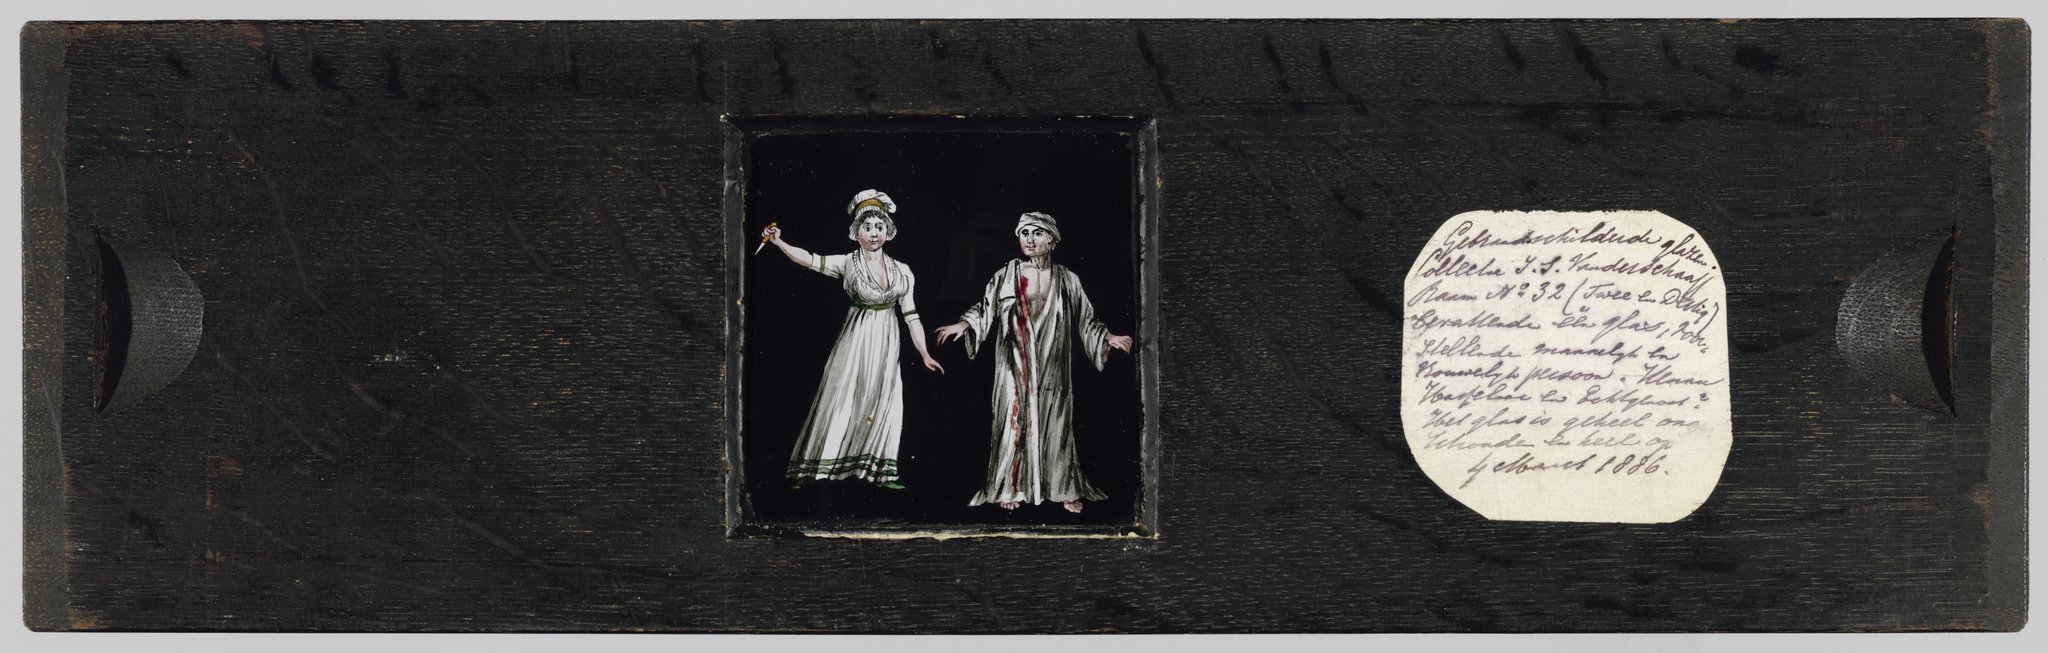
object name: lantern slide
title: Moordenares en haar slachtoffer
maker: Anonymous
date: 1793-1830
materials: glass, wood, oil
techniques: painted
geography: france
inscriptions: label: ‘'Gebrandschilderde glazen. Collectie J. I. Van der Schaaff Baarn. Nr. 32 (twee en dertig) bevattende één glas, voorstellende een mannelijk en vrouwelijk persoon. Het glas is geheel ongeschonden en heel op 4 maart 1886'’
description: Vierkante glasplaat in houten vatting. Een vrouw gekleed in jurk en met muts op, ten voeten uit, met mes in haar geheven hand. Naast haar een man, ten voeten uit, in witte kamerjas en met een tulband om zijn hoofd. In zijn borststreek een bloedende wond. Vrijwel zeker Jean-Paul Marat en zijn moordenares Charlotte Corday. De achtergrond is zwart.